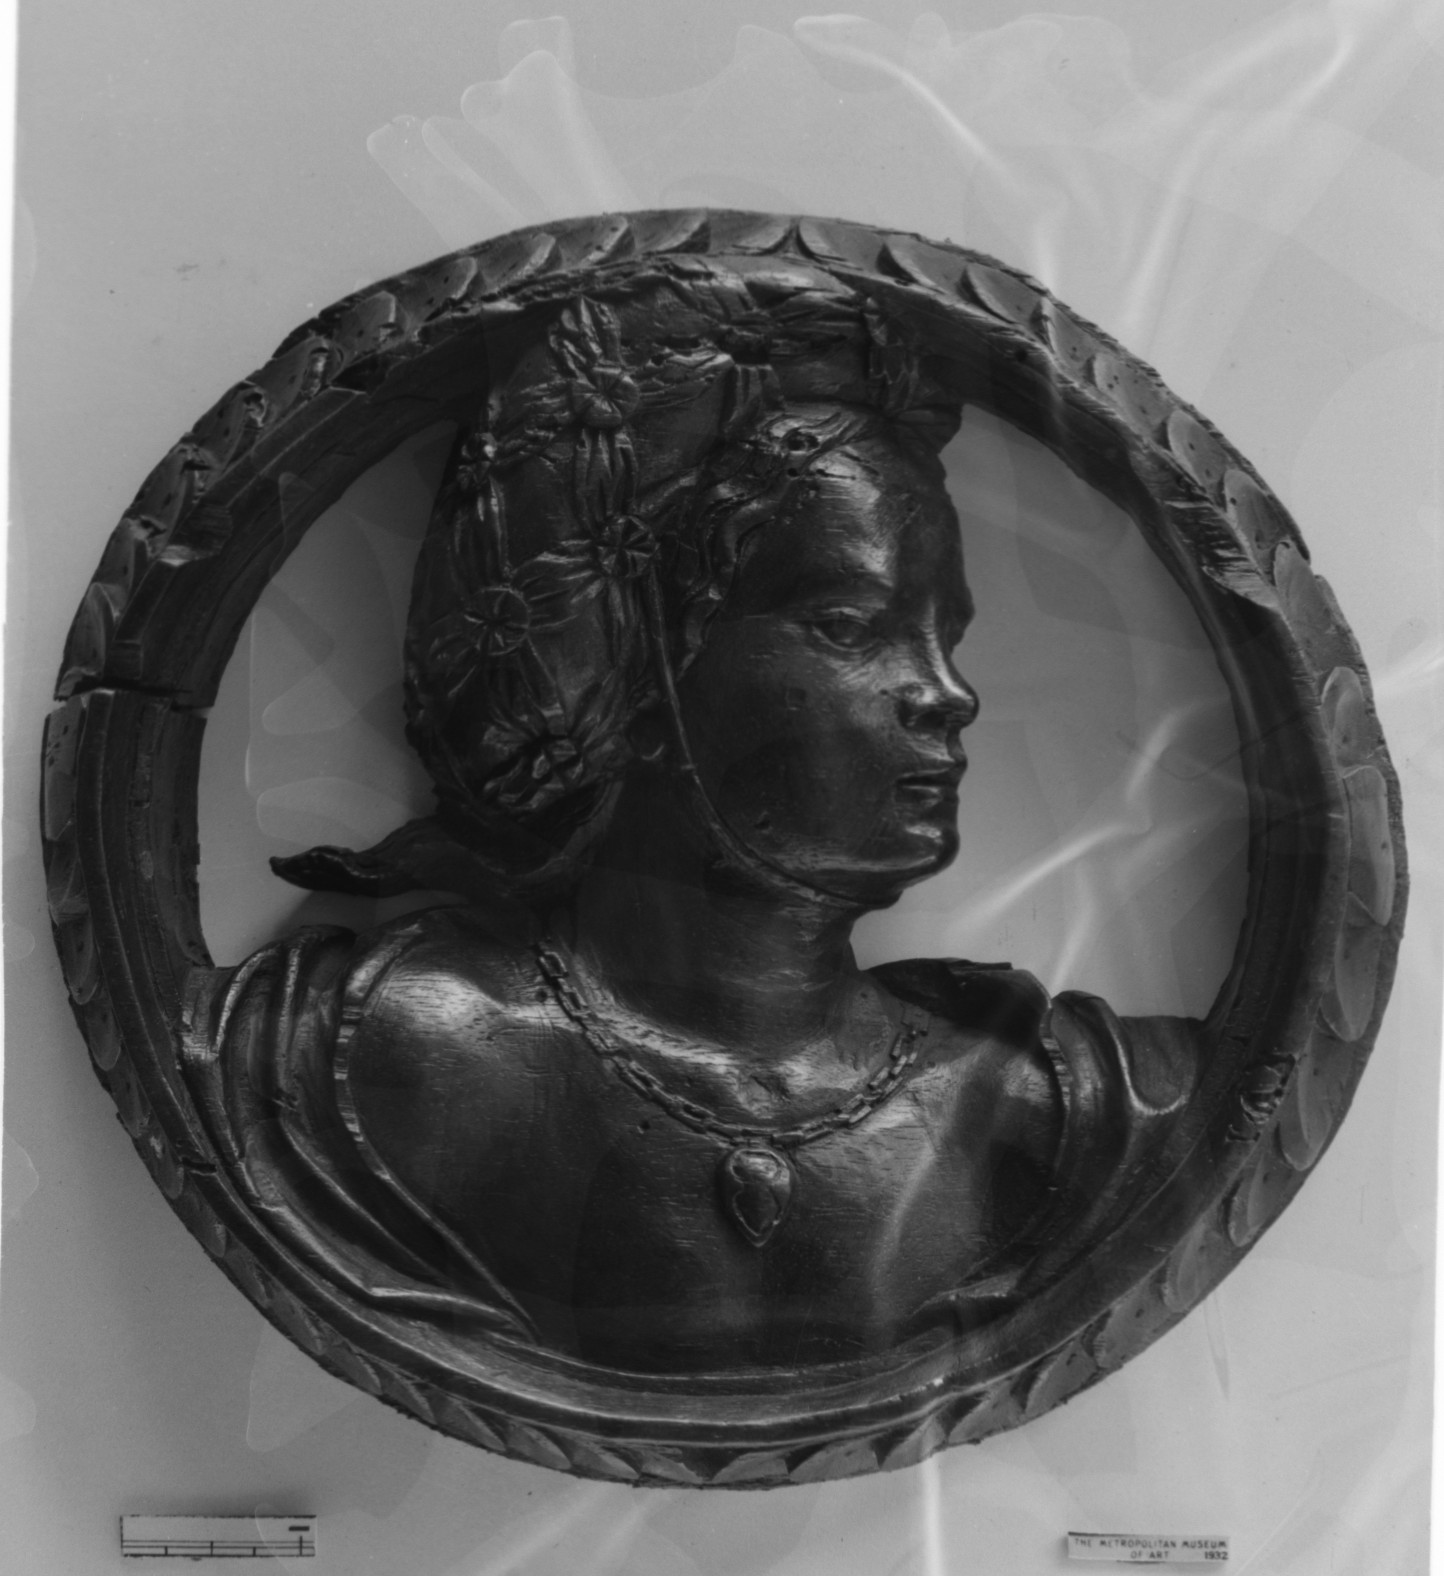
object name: medallion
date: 1501-1550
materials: wood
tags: portraits,women